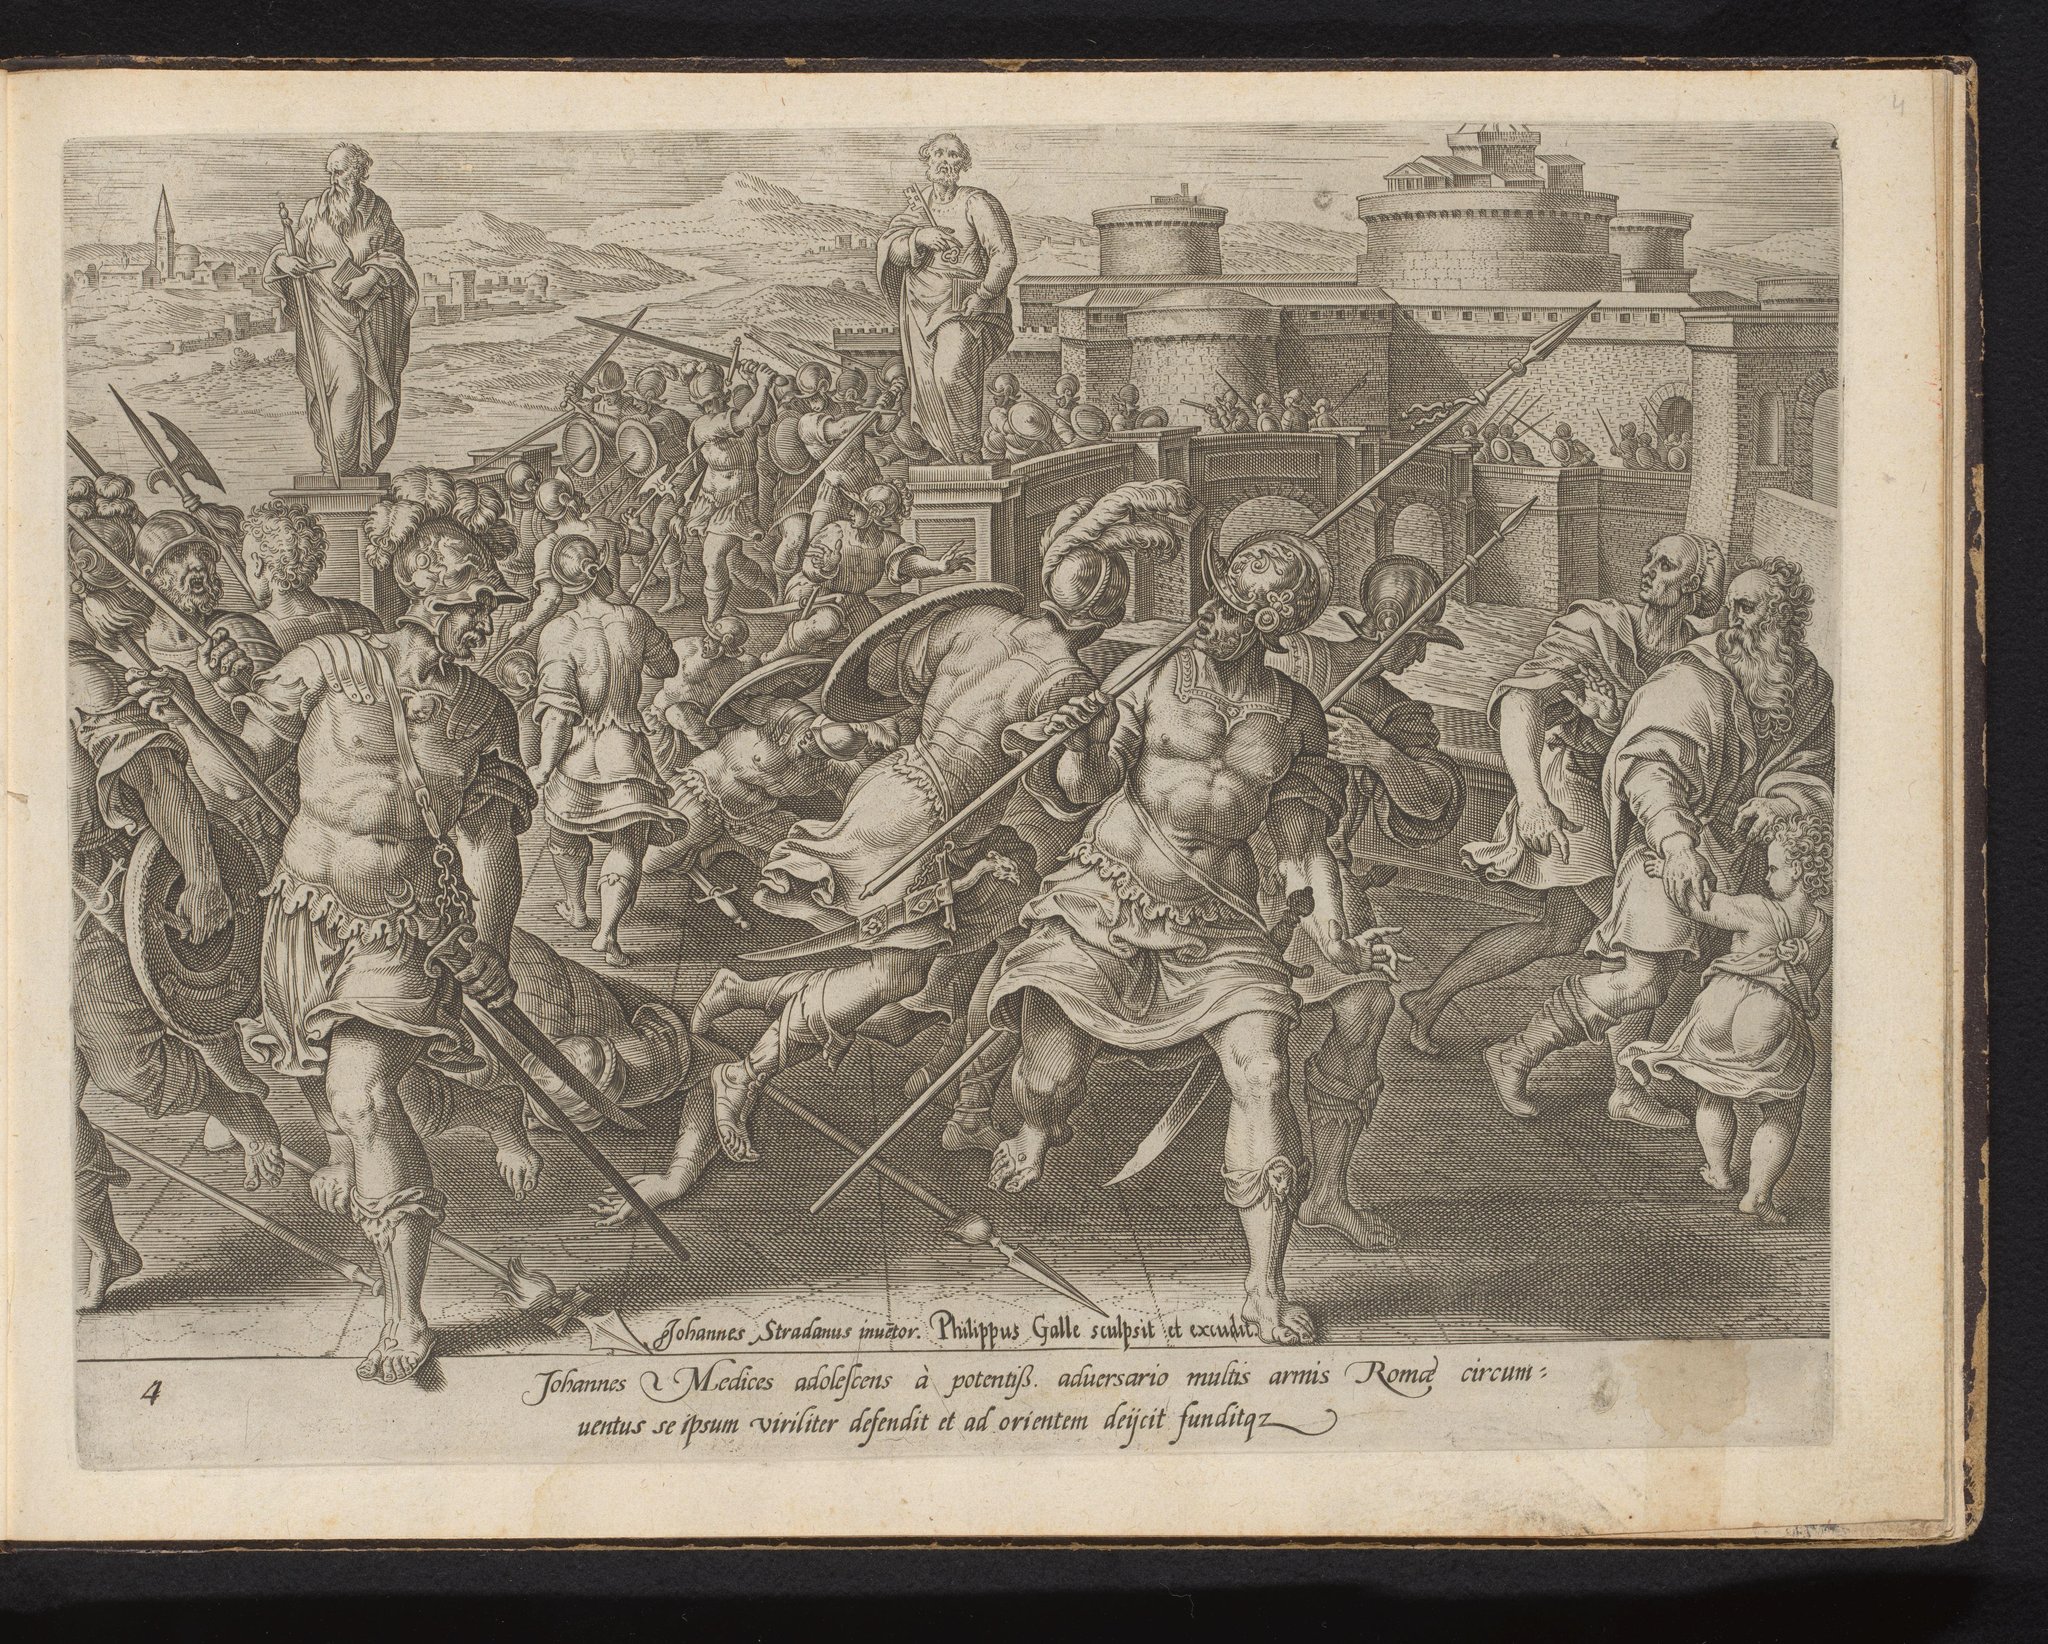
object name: album leaf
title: Familiegeschiedenis van het geslacht de' Medici (deel 1)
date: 1583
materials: paper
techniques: engraving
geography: antwerp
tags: battle, fighting in general, street-fights, riots, rome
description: De jonge Giovanni de Medici, bijgenaamd 'dalle Bande Nere', wordt tijdens een straatgevecht op de Engelenbrug omsingeld door leden van de Orsini-familie. Hij slaat wild om zich heen met zijn zwaard en jaagt de belegeraars op de vlucht. Rechts vlucht een gezin weg van de onveilige situatie. De standbeelden aan het begin van de brug verbeelden Paulus en Petrus. In de ondermarge twee regels tekst in het Latijn. Linksonder is het nummer 1 met pen veranderd in 4. De prent maakt deel uit van een album.